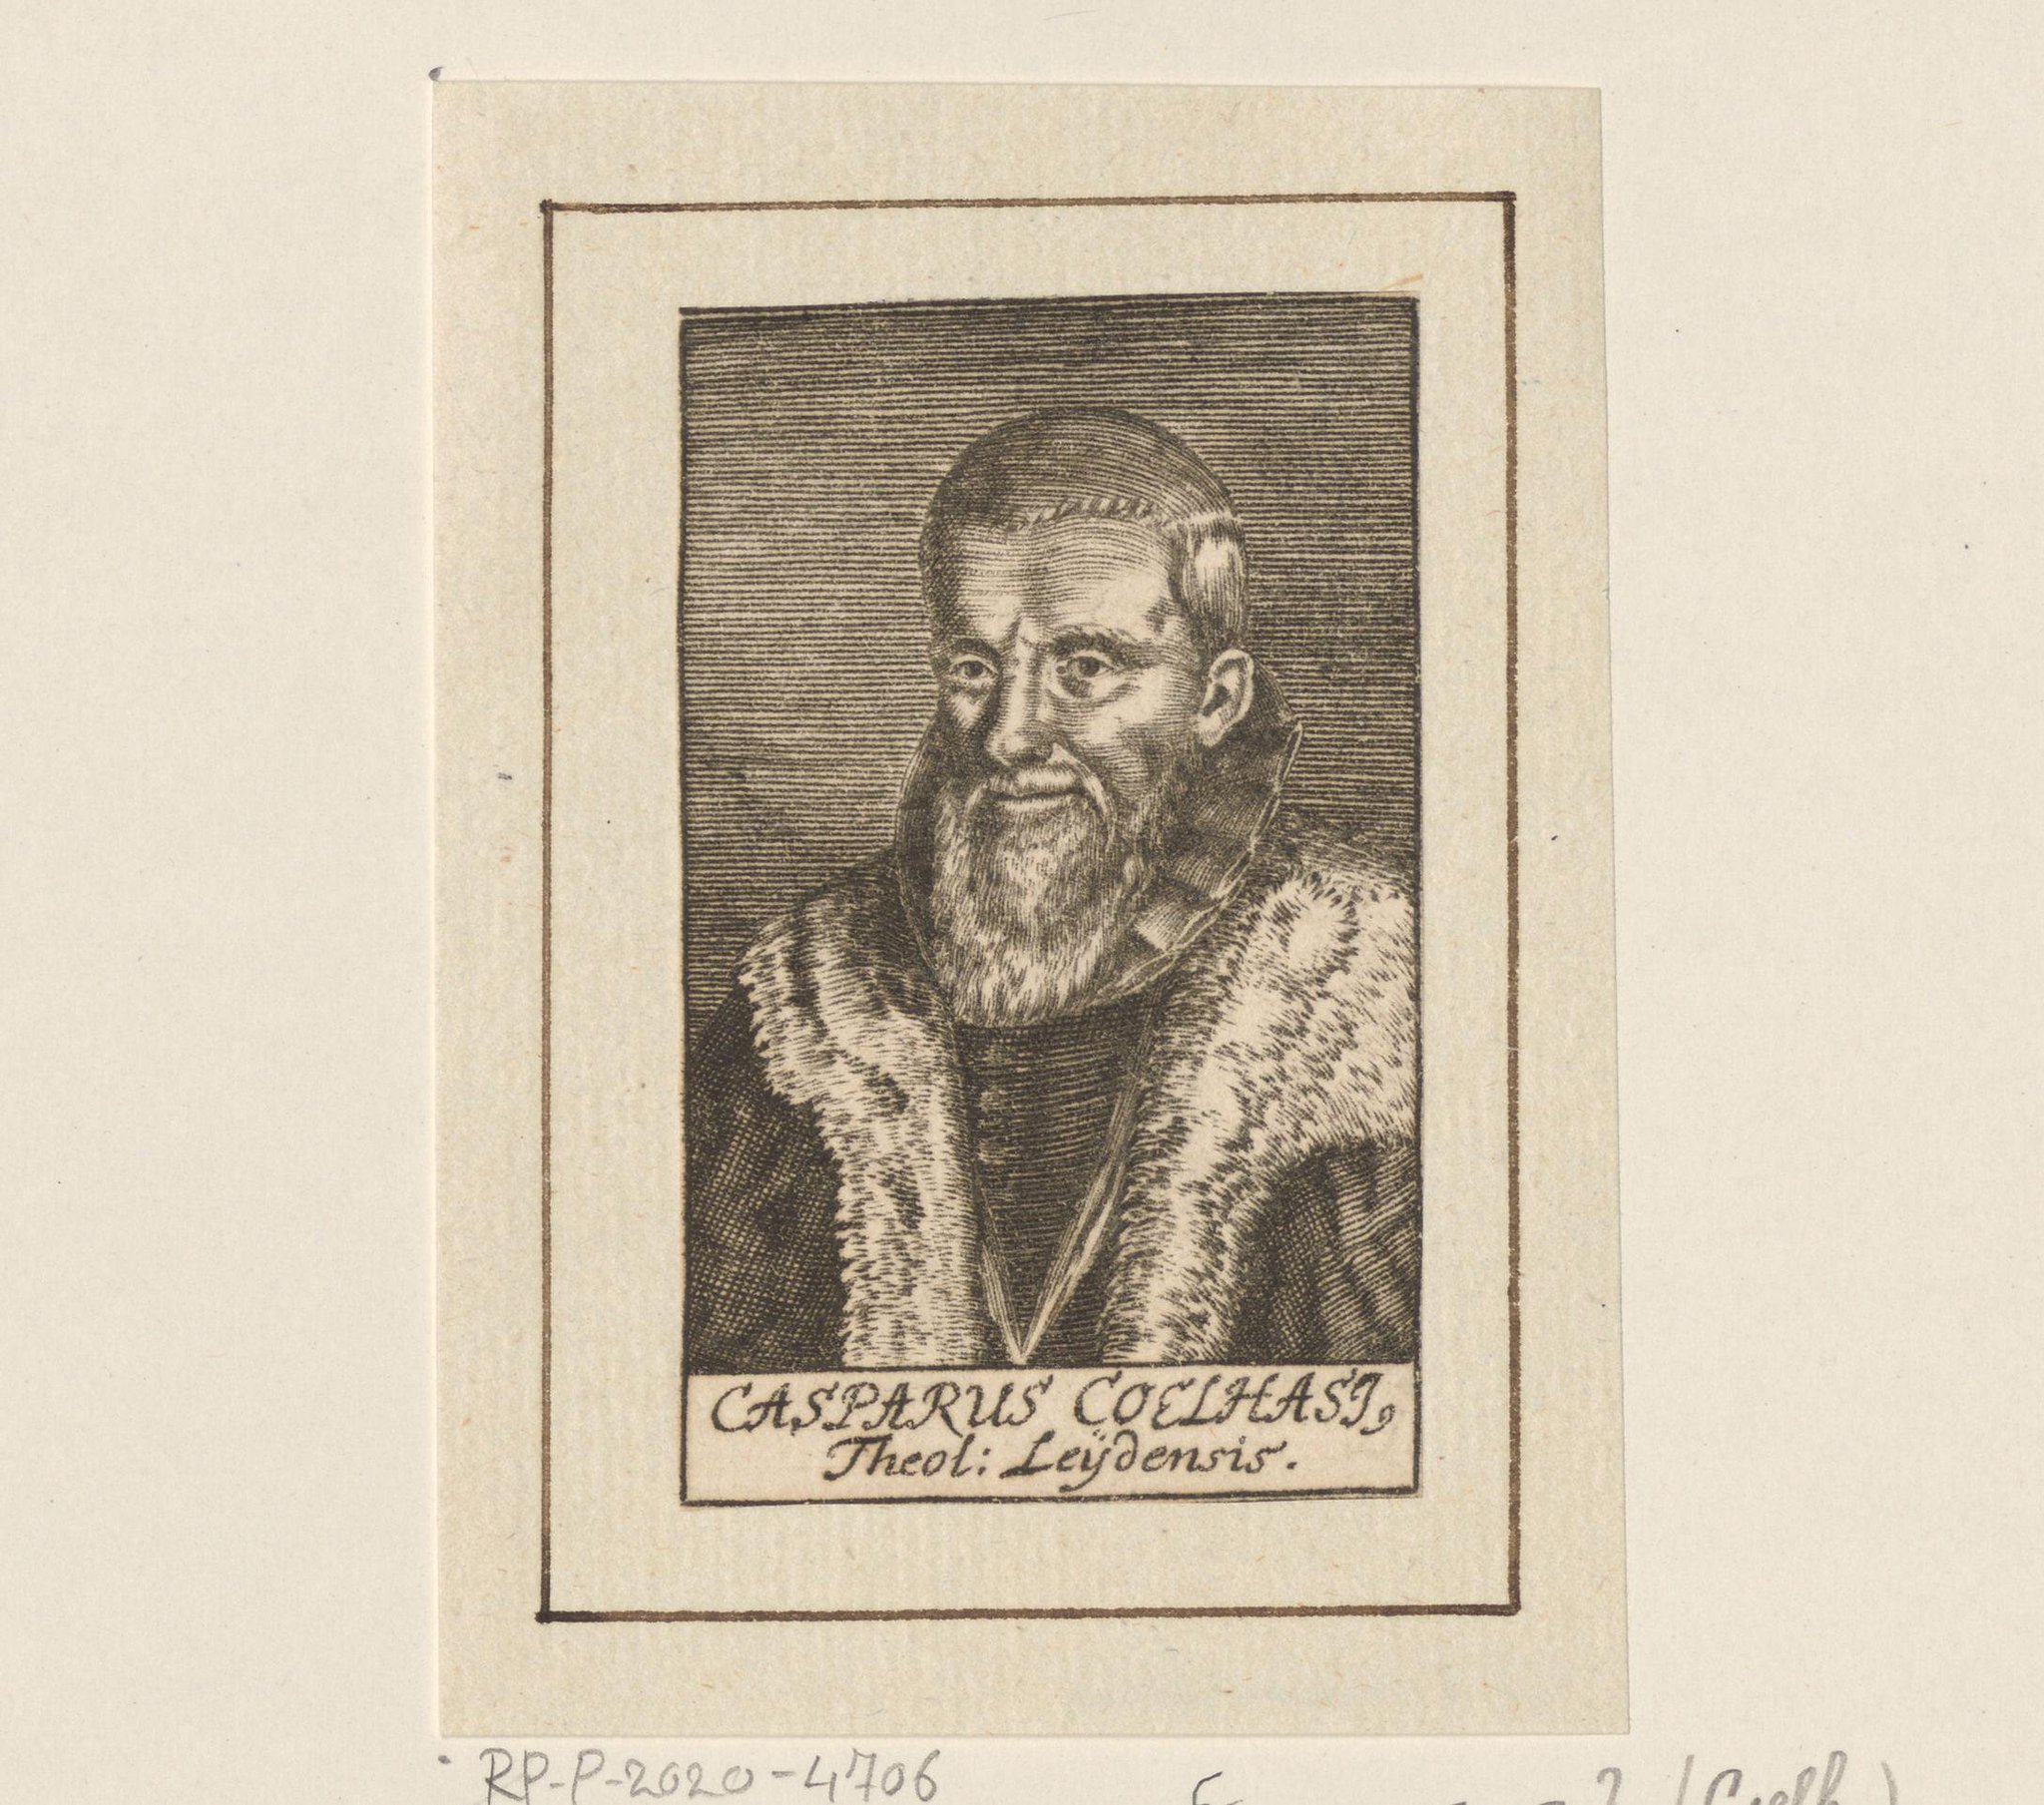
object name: print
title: Portret van Caspar Janszoon Coolhaes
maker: Anonymous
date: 1688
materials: paper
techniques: engraving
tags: cologne, theologian, historical persons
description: Prent maakt deel uit van een grotere prent die later is verknipt. Prent waarschijnlijk uit: Freher, Paul. Theatrum virorum eruditione clarorum. Neurenberg: Johann Hoffmann, 1688.